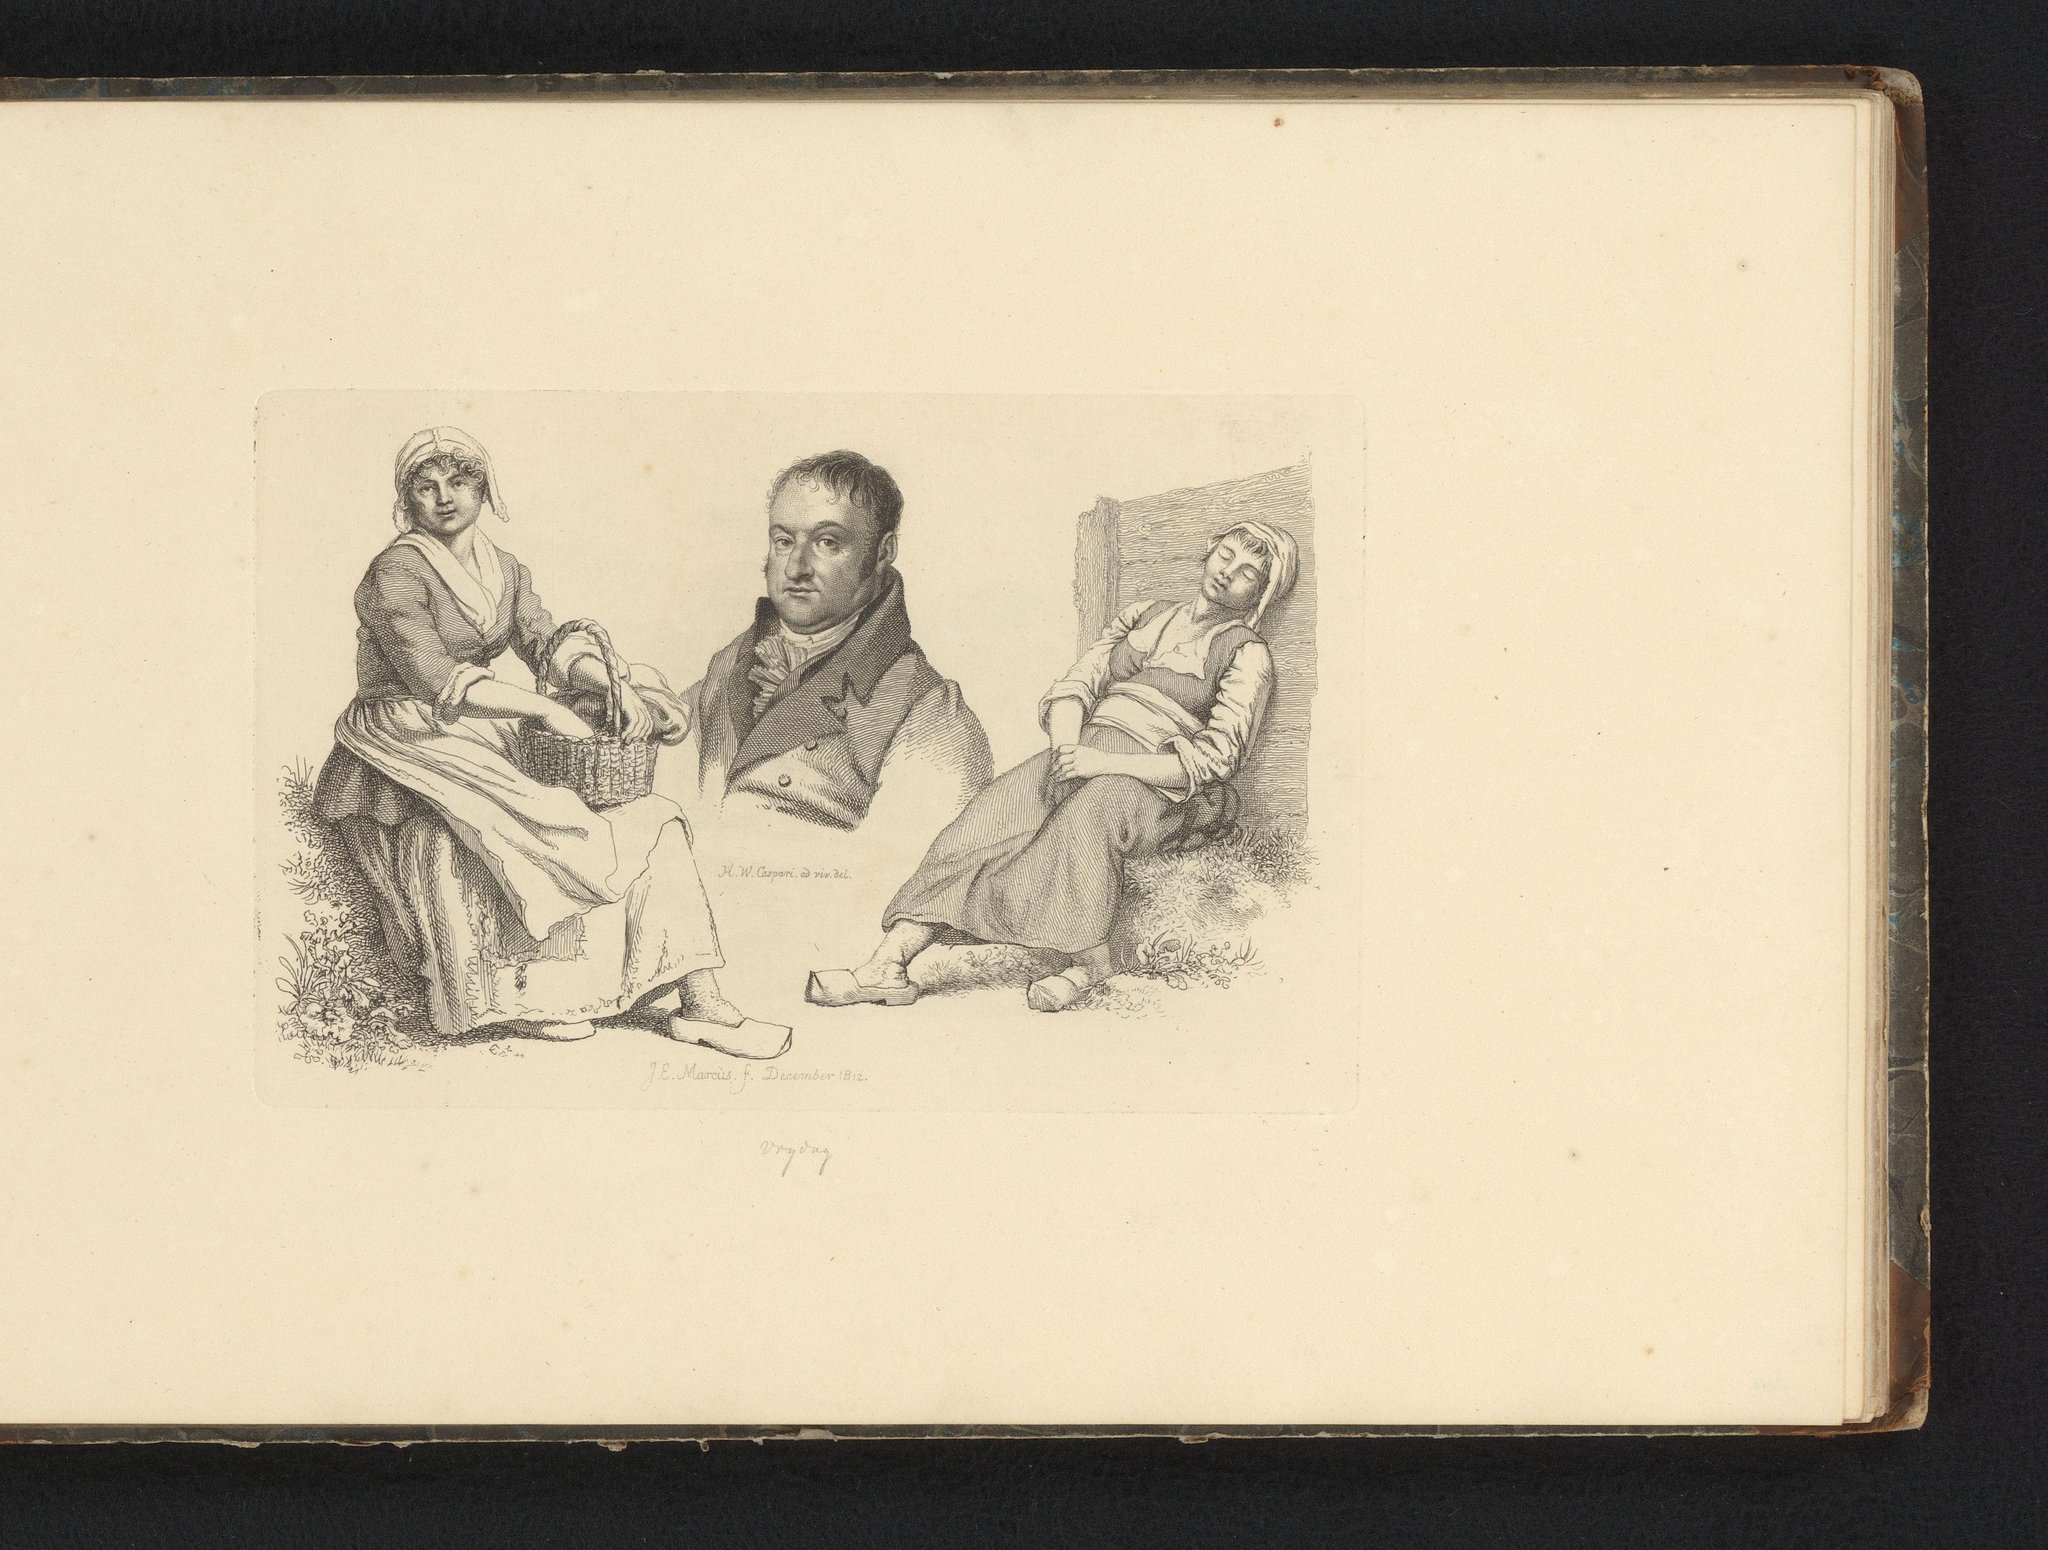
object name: print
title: Studiebeelden en fragmenten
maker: jacob ernst marcus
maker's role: draughtsman, print maker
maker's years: 1774-1826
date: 1812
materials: paper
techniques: etching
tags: the hague, amsterdam, print maker, daniël vrijdag, engraver, etcher, farmers - aa - female farmer, farmer's wife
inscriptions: date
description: Deze prent maakt deel uit van een album.